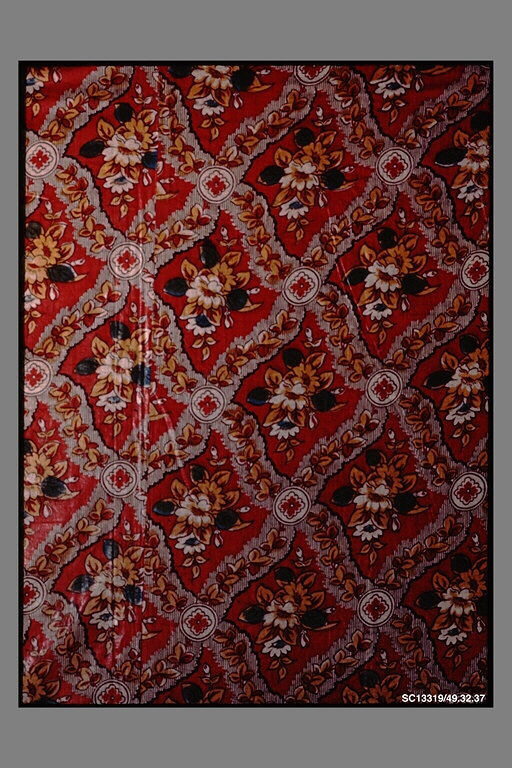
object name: piece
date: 1815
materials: cotton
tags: flowers,leaves